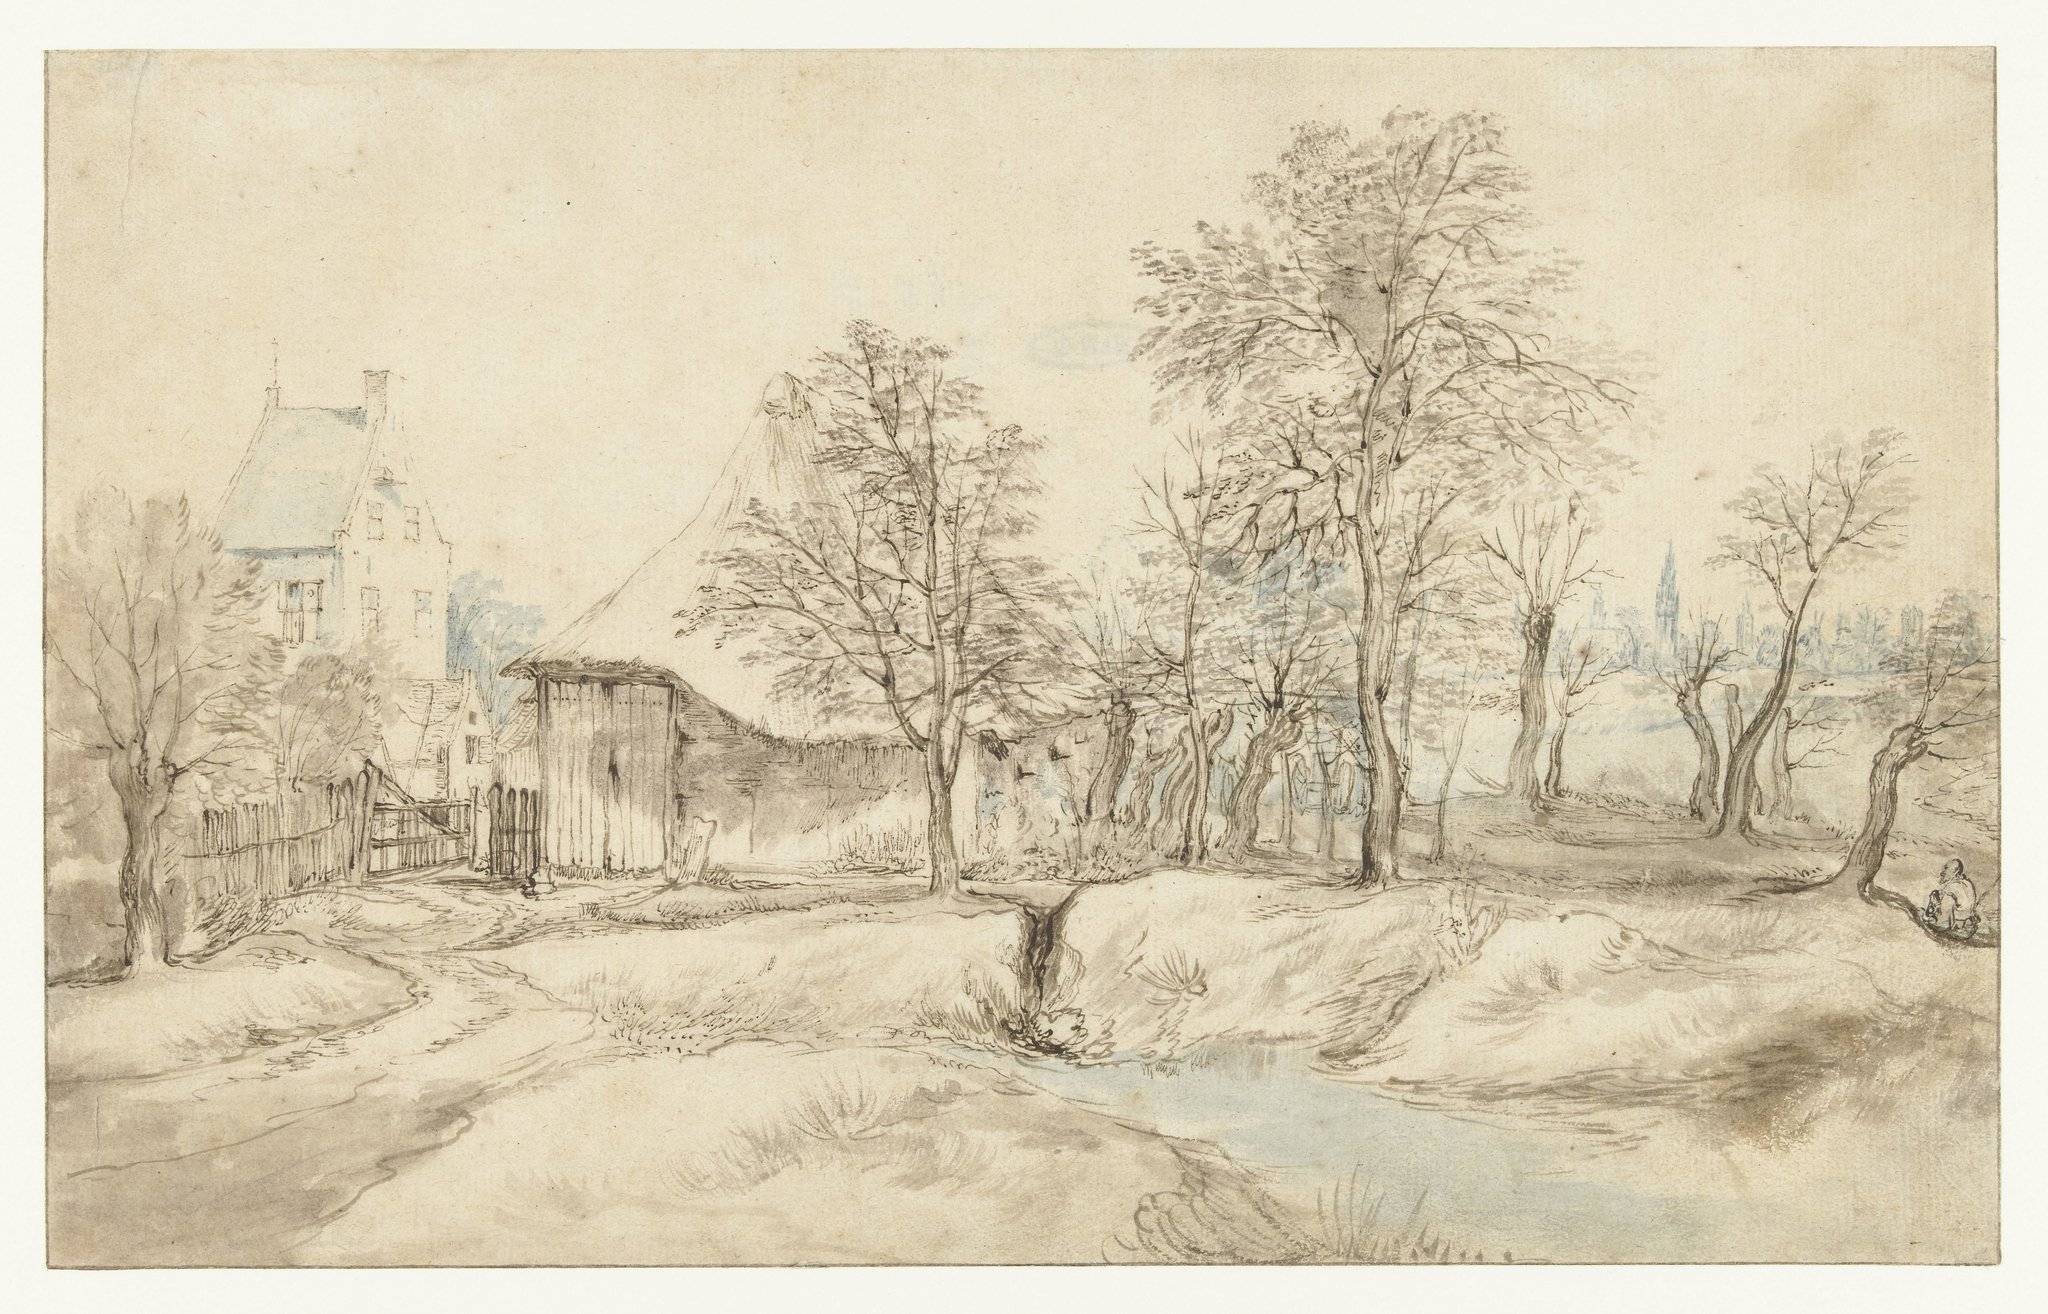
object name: drawing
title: Hoeve tussen bomen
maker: jan brueghel (i)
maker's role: draughtsman, painter, print maker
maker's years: 1568-1625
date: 1578-1623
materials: paper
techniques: brush, pen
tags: farm (building)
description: Een hoeve met bijgebouwen tussen bomen; rechts het profiel van een stad.